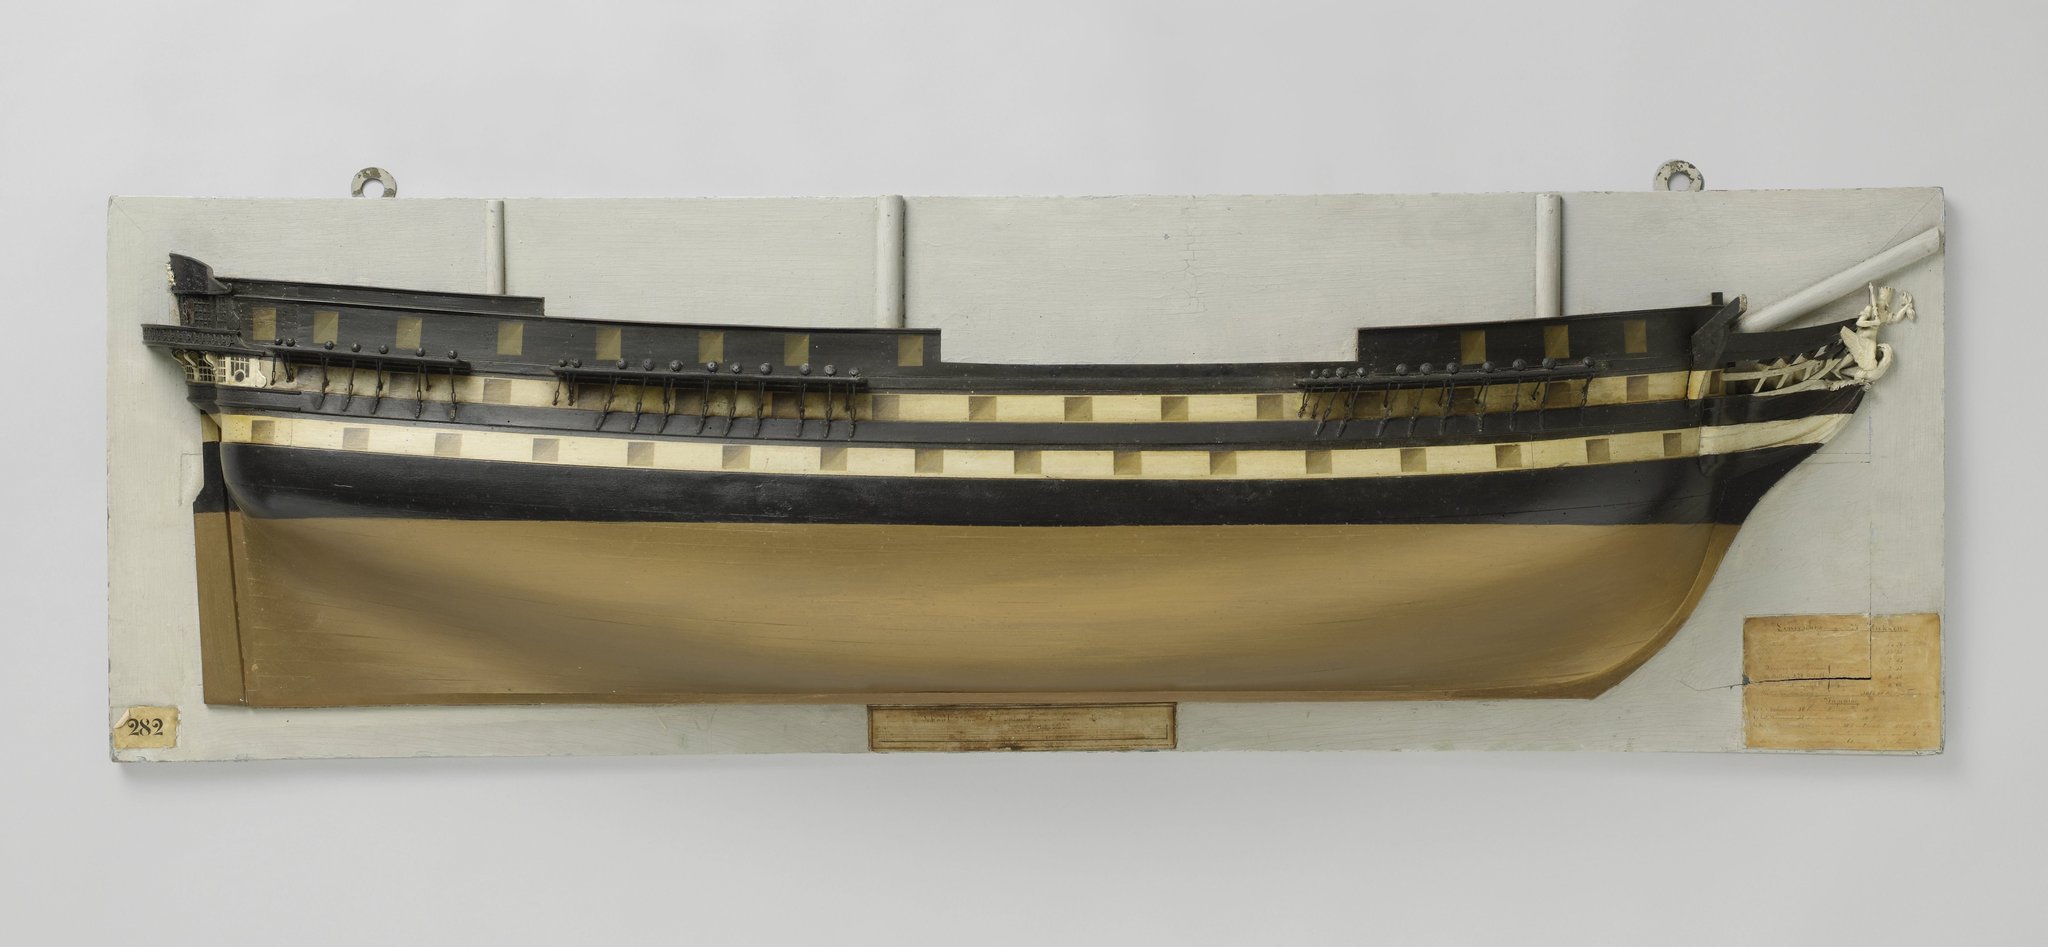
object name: builder's model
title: Half Model of a 74-Gun Ship of the Line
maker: Anonymous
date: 1825-1833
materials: wood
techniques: polychromy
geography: netherlands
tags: jupiter (schip), kortenaer (schip)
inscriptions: label, bottom left: ‘282’ old inventory number, inscription, bottom right, on a piece of paper, in ink: ‘Linieschip van 74 Stukken. / [followed by measurements and armament]’, scale, bottom centre: paper scale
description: Geheel beplankt en gepolychromeerd mallenmodel (stuurboord) van een driemaster. Zes en veertig geschutpoorten verdeeld over drie dekken. Het schegbeeld is een gekroonde man met een scepter in de rechterhand en een vlammenbundel in de opgeheven linkerhand, staande op een vogel. Op de kraanbalk een leeuwenkop. Rond achterschip met een hek van twee verdiepingen, uitvoerig versierd, met halfronde galerij middenachter. De westergang aan de bovenste verdieping, die om de galerij heenloopt, wordt gesteund door versierde knieën. De verschansing boven het hek is beschadigd. Onder de galerij het hennegat: recht roer met vierkante roerkoning. De zeeg loopt iets op aan beide uiteinden, twee berghouten en één reehout. Het onderwaterschip is vrij vlak, maar achter scherp weggesneden. Schaal 1:50 (schaal op model).